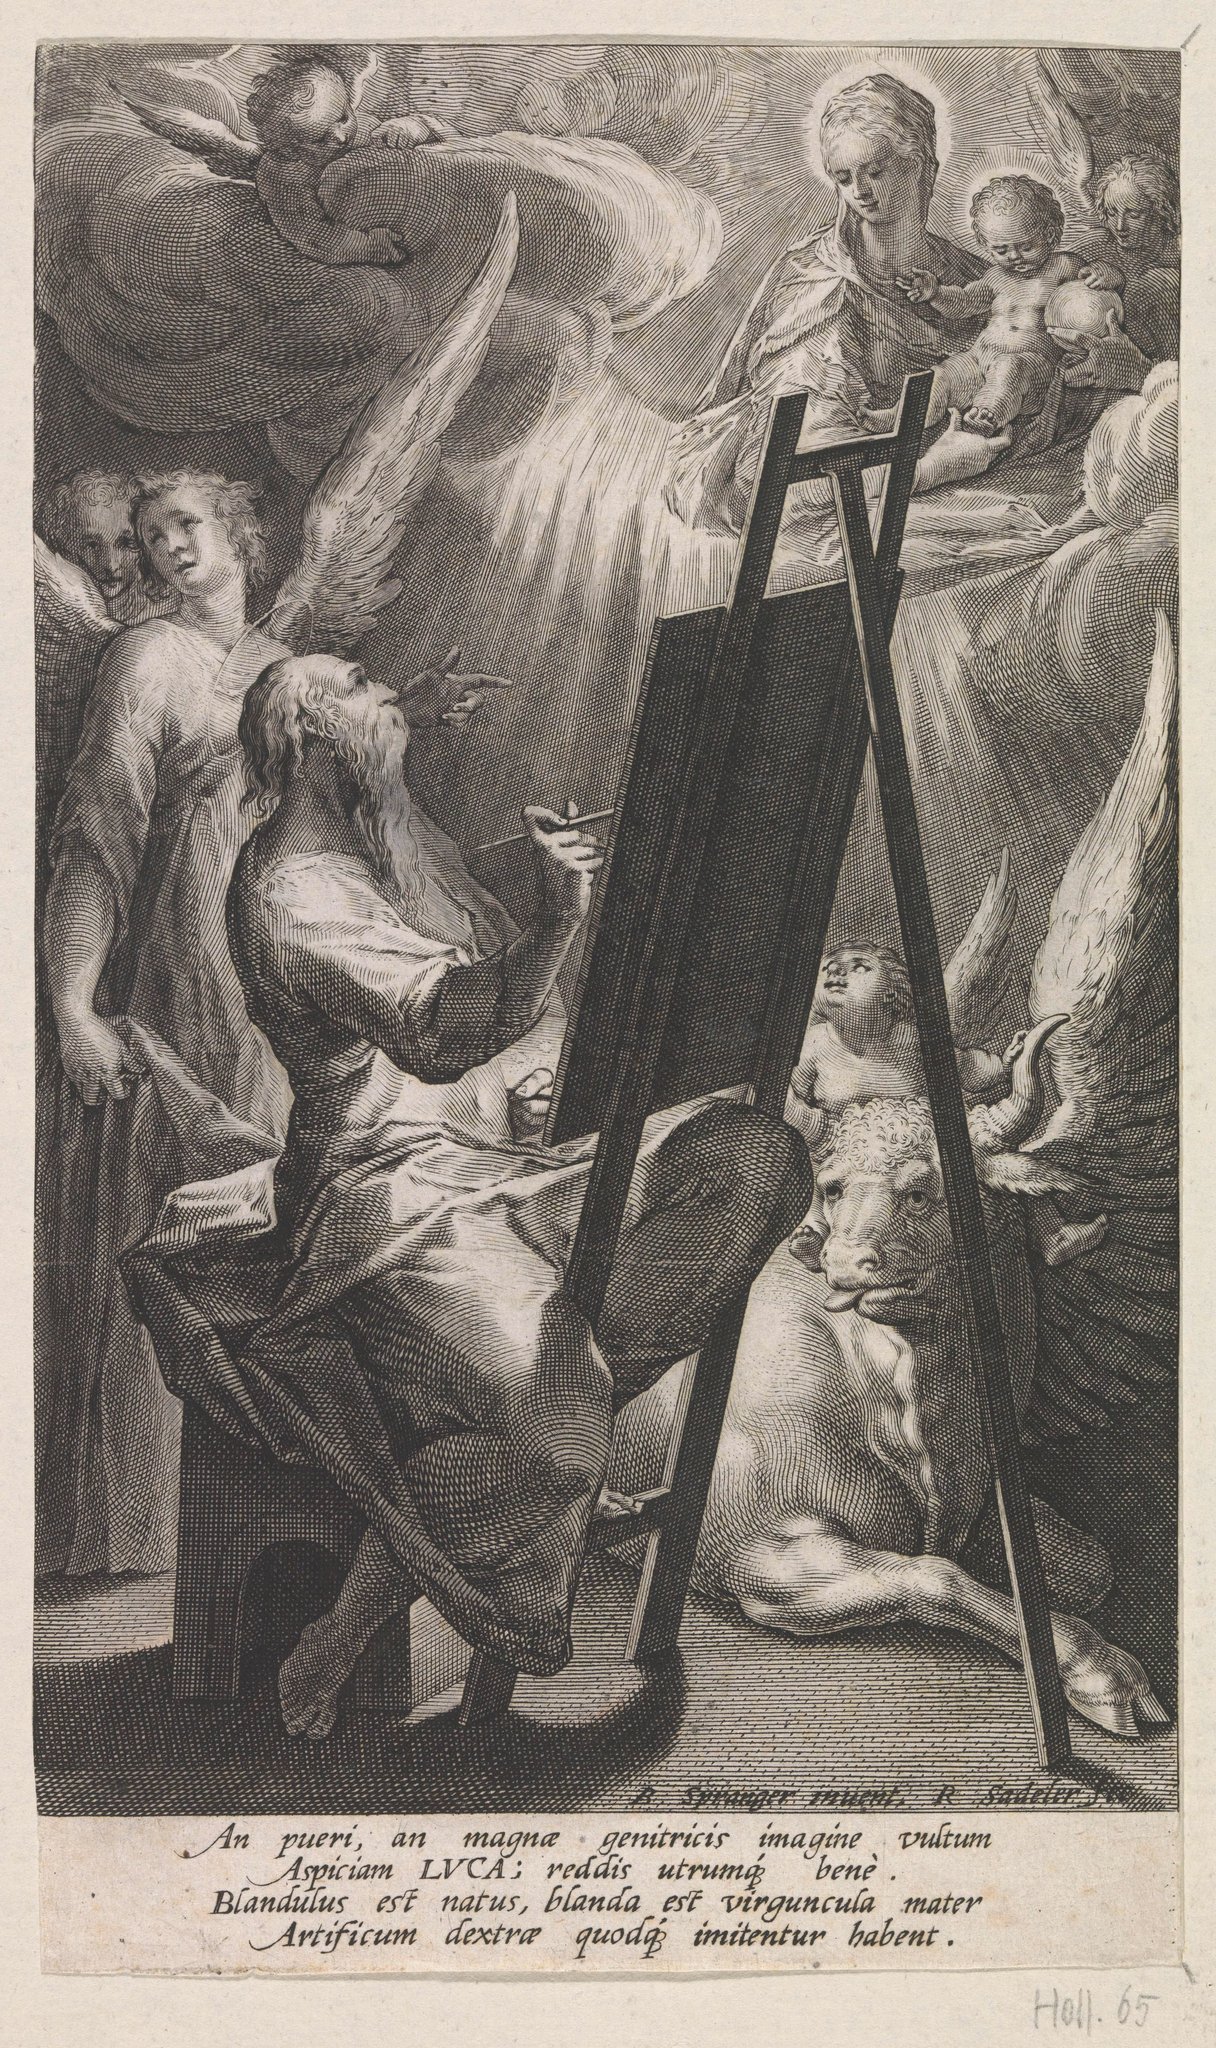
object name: print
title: Lucas de Evangelist schildert Maria met het Christuskind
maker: bartholomeus spranger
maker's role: draughtsman, painter, print maker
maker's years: 1546-1611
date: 1582-1632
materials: paper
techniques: engraving, etching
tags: st.luke painting or drawing the madonna (i.e. mary and the christ-child), sometimes joseph present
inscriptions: collector's mark: Lugt 240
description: De H. Lucas de evangelist zit achter een schildersezel en kijkt naar de verschijning van Maria en het Christuskind. Naast hem op de grond de gevleugelde os als zijn attribuut.